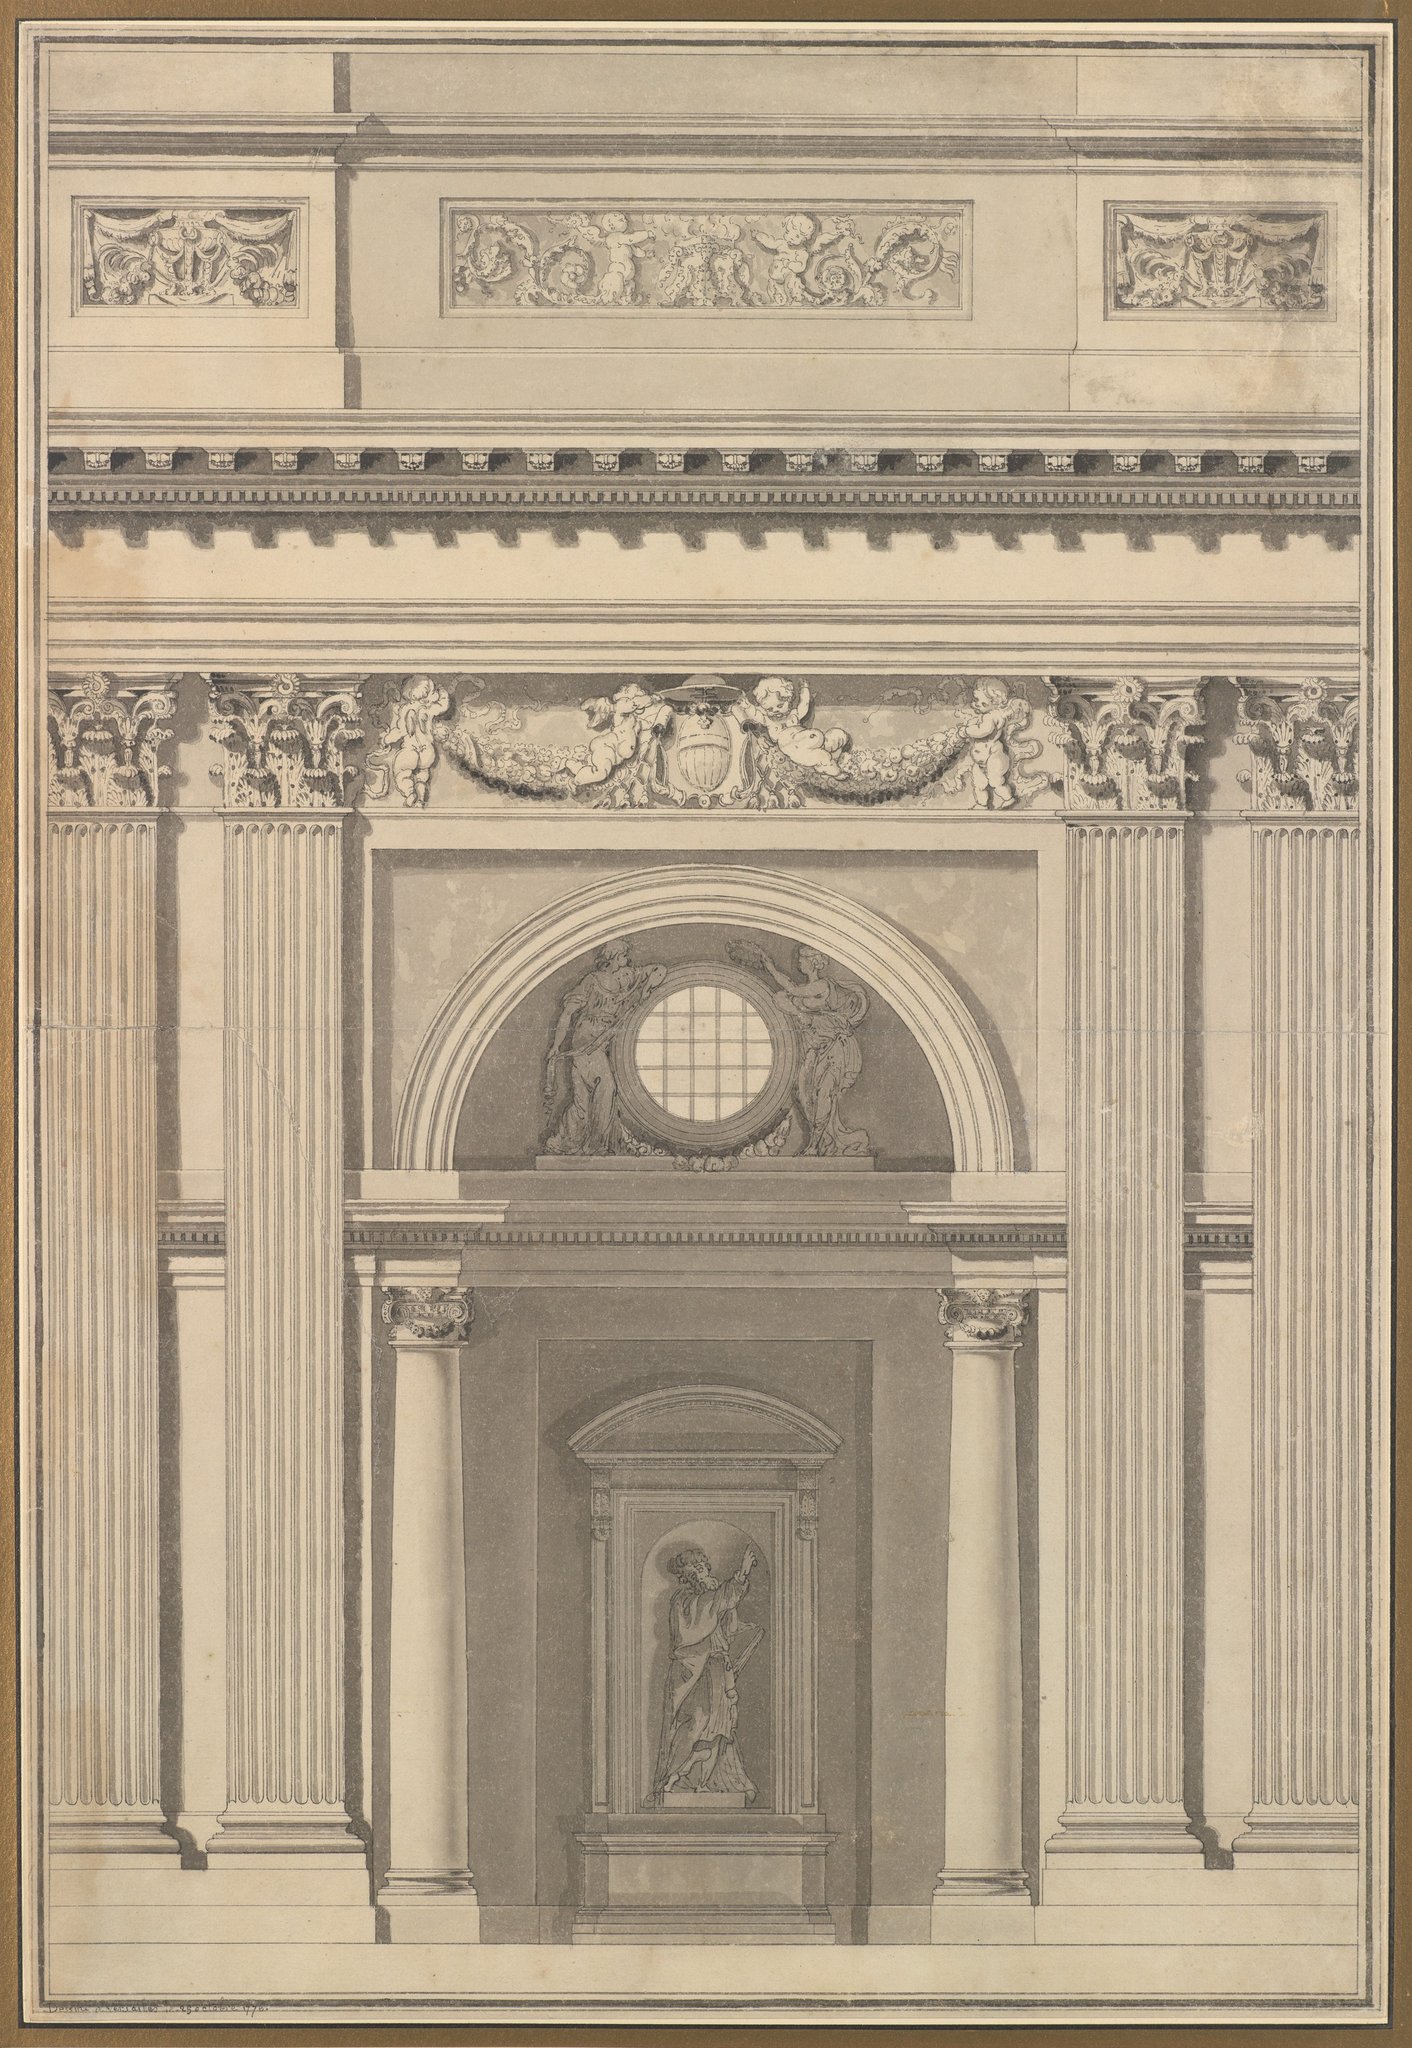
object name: drawing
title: Elevation of a Wall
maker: jean guillaume moitte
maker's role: artist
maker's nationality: french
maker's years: 1746-1810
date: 1776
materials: ink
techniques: brush, pen, wash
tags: architecture